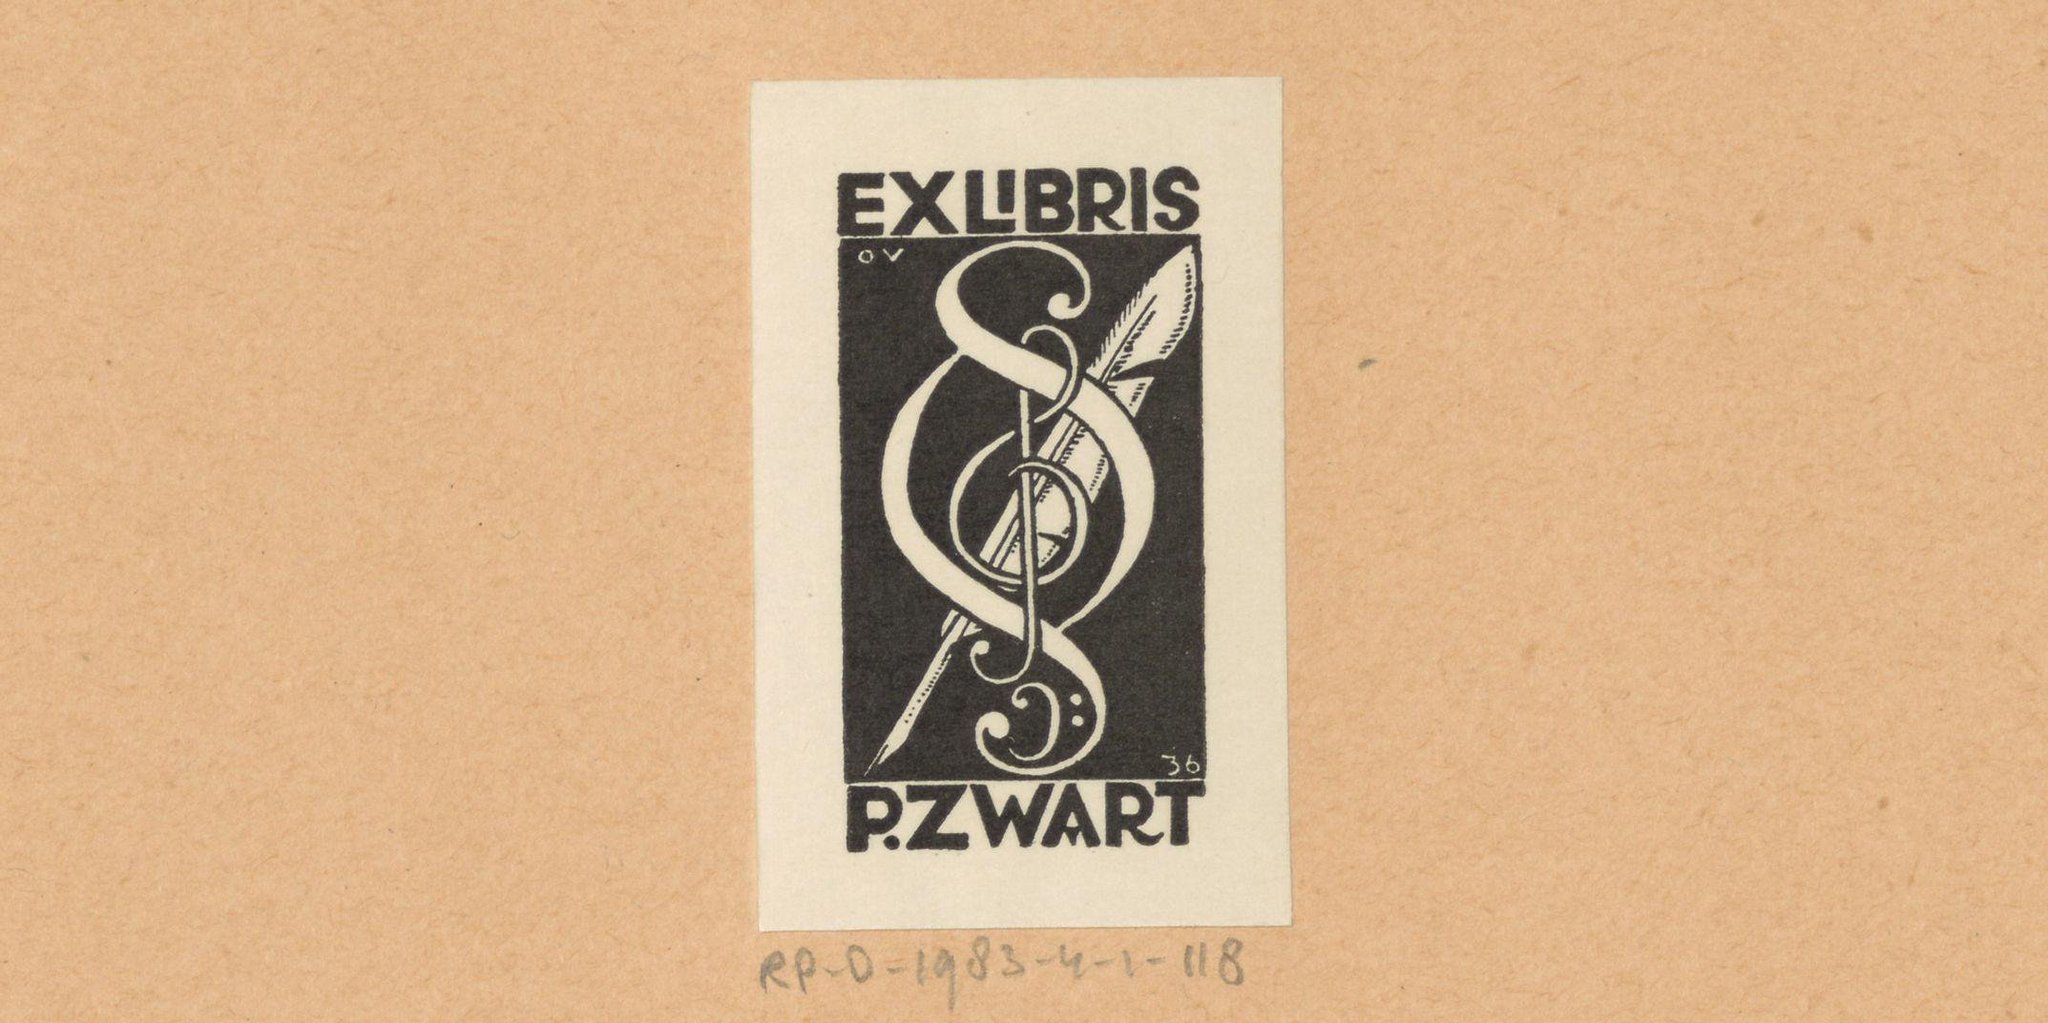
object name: bookplate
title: Ex libris van P. Zwart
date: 1936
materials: paper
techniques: printing block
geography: netherlands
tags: notation of music, quill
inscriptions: inscription: ‘1936. Cliché bestemd (...) muziek = sleutels.’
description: Ex libris was bestemd voor een notaris, een liefhebber van muziek. Het paragraafteken staat voor het notariaat, de muzieksleutels duiden op zijn liefhebberij.